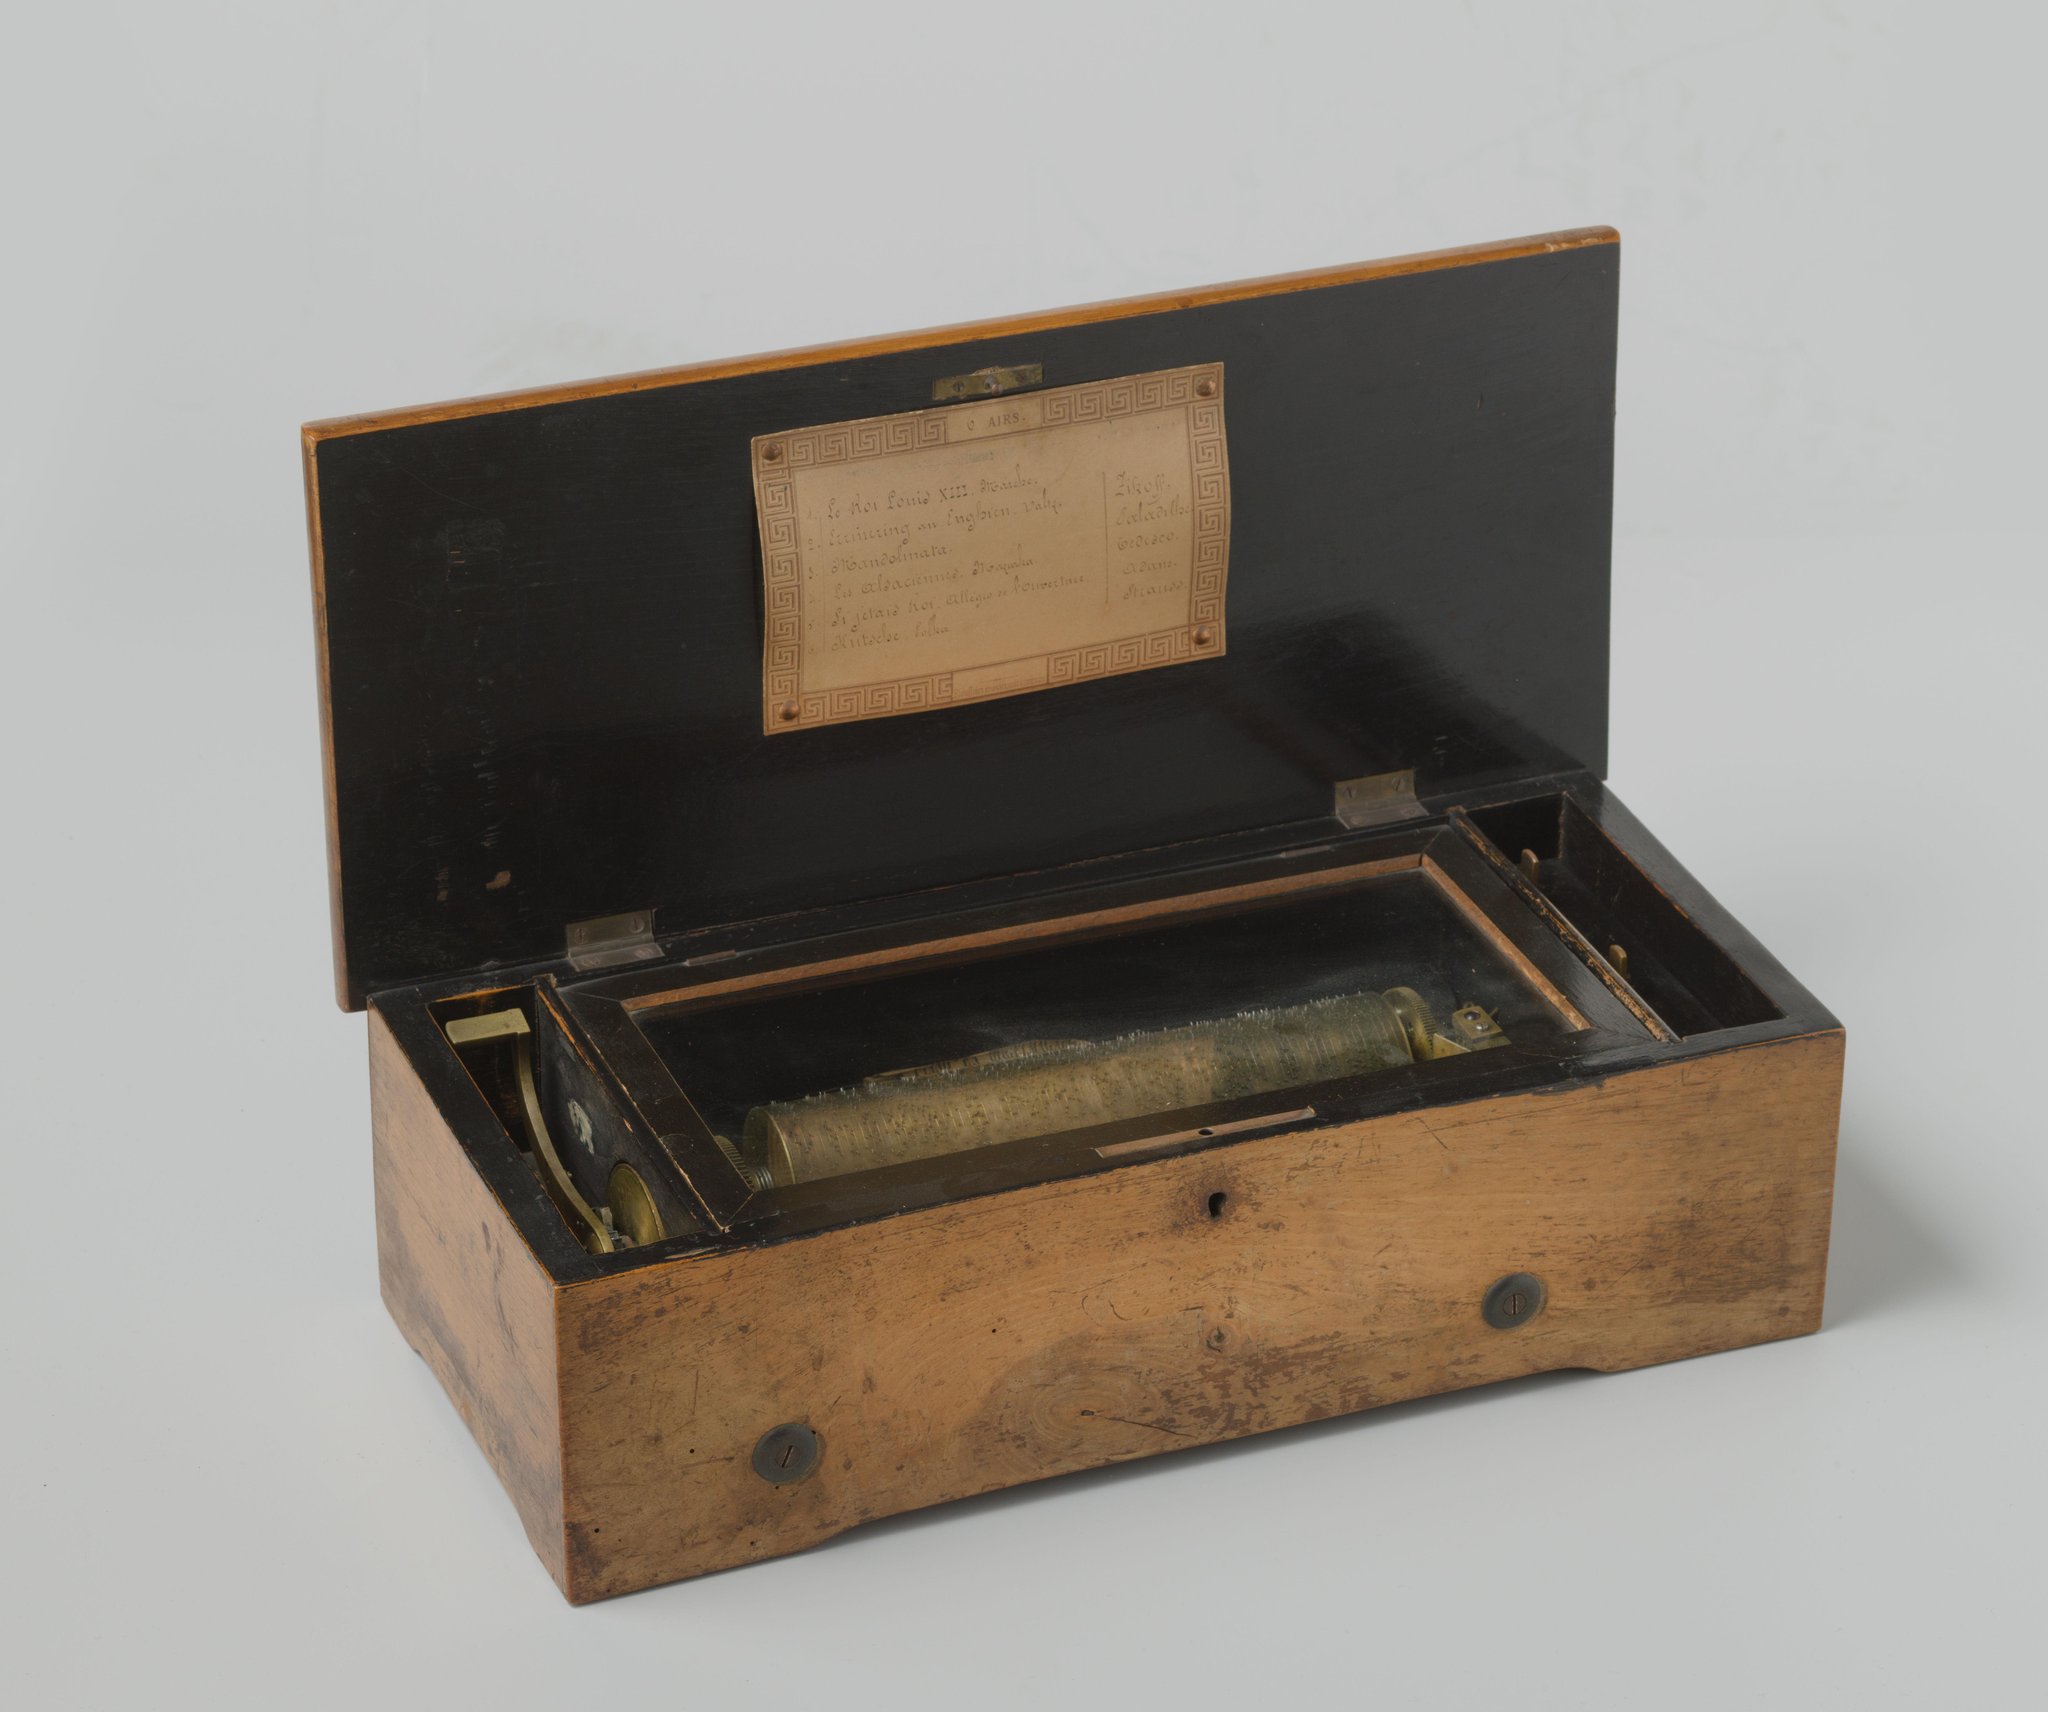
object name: musical instrument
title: Musical box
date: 1874-1879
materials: wood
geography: sainte-croix